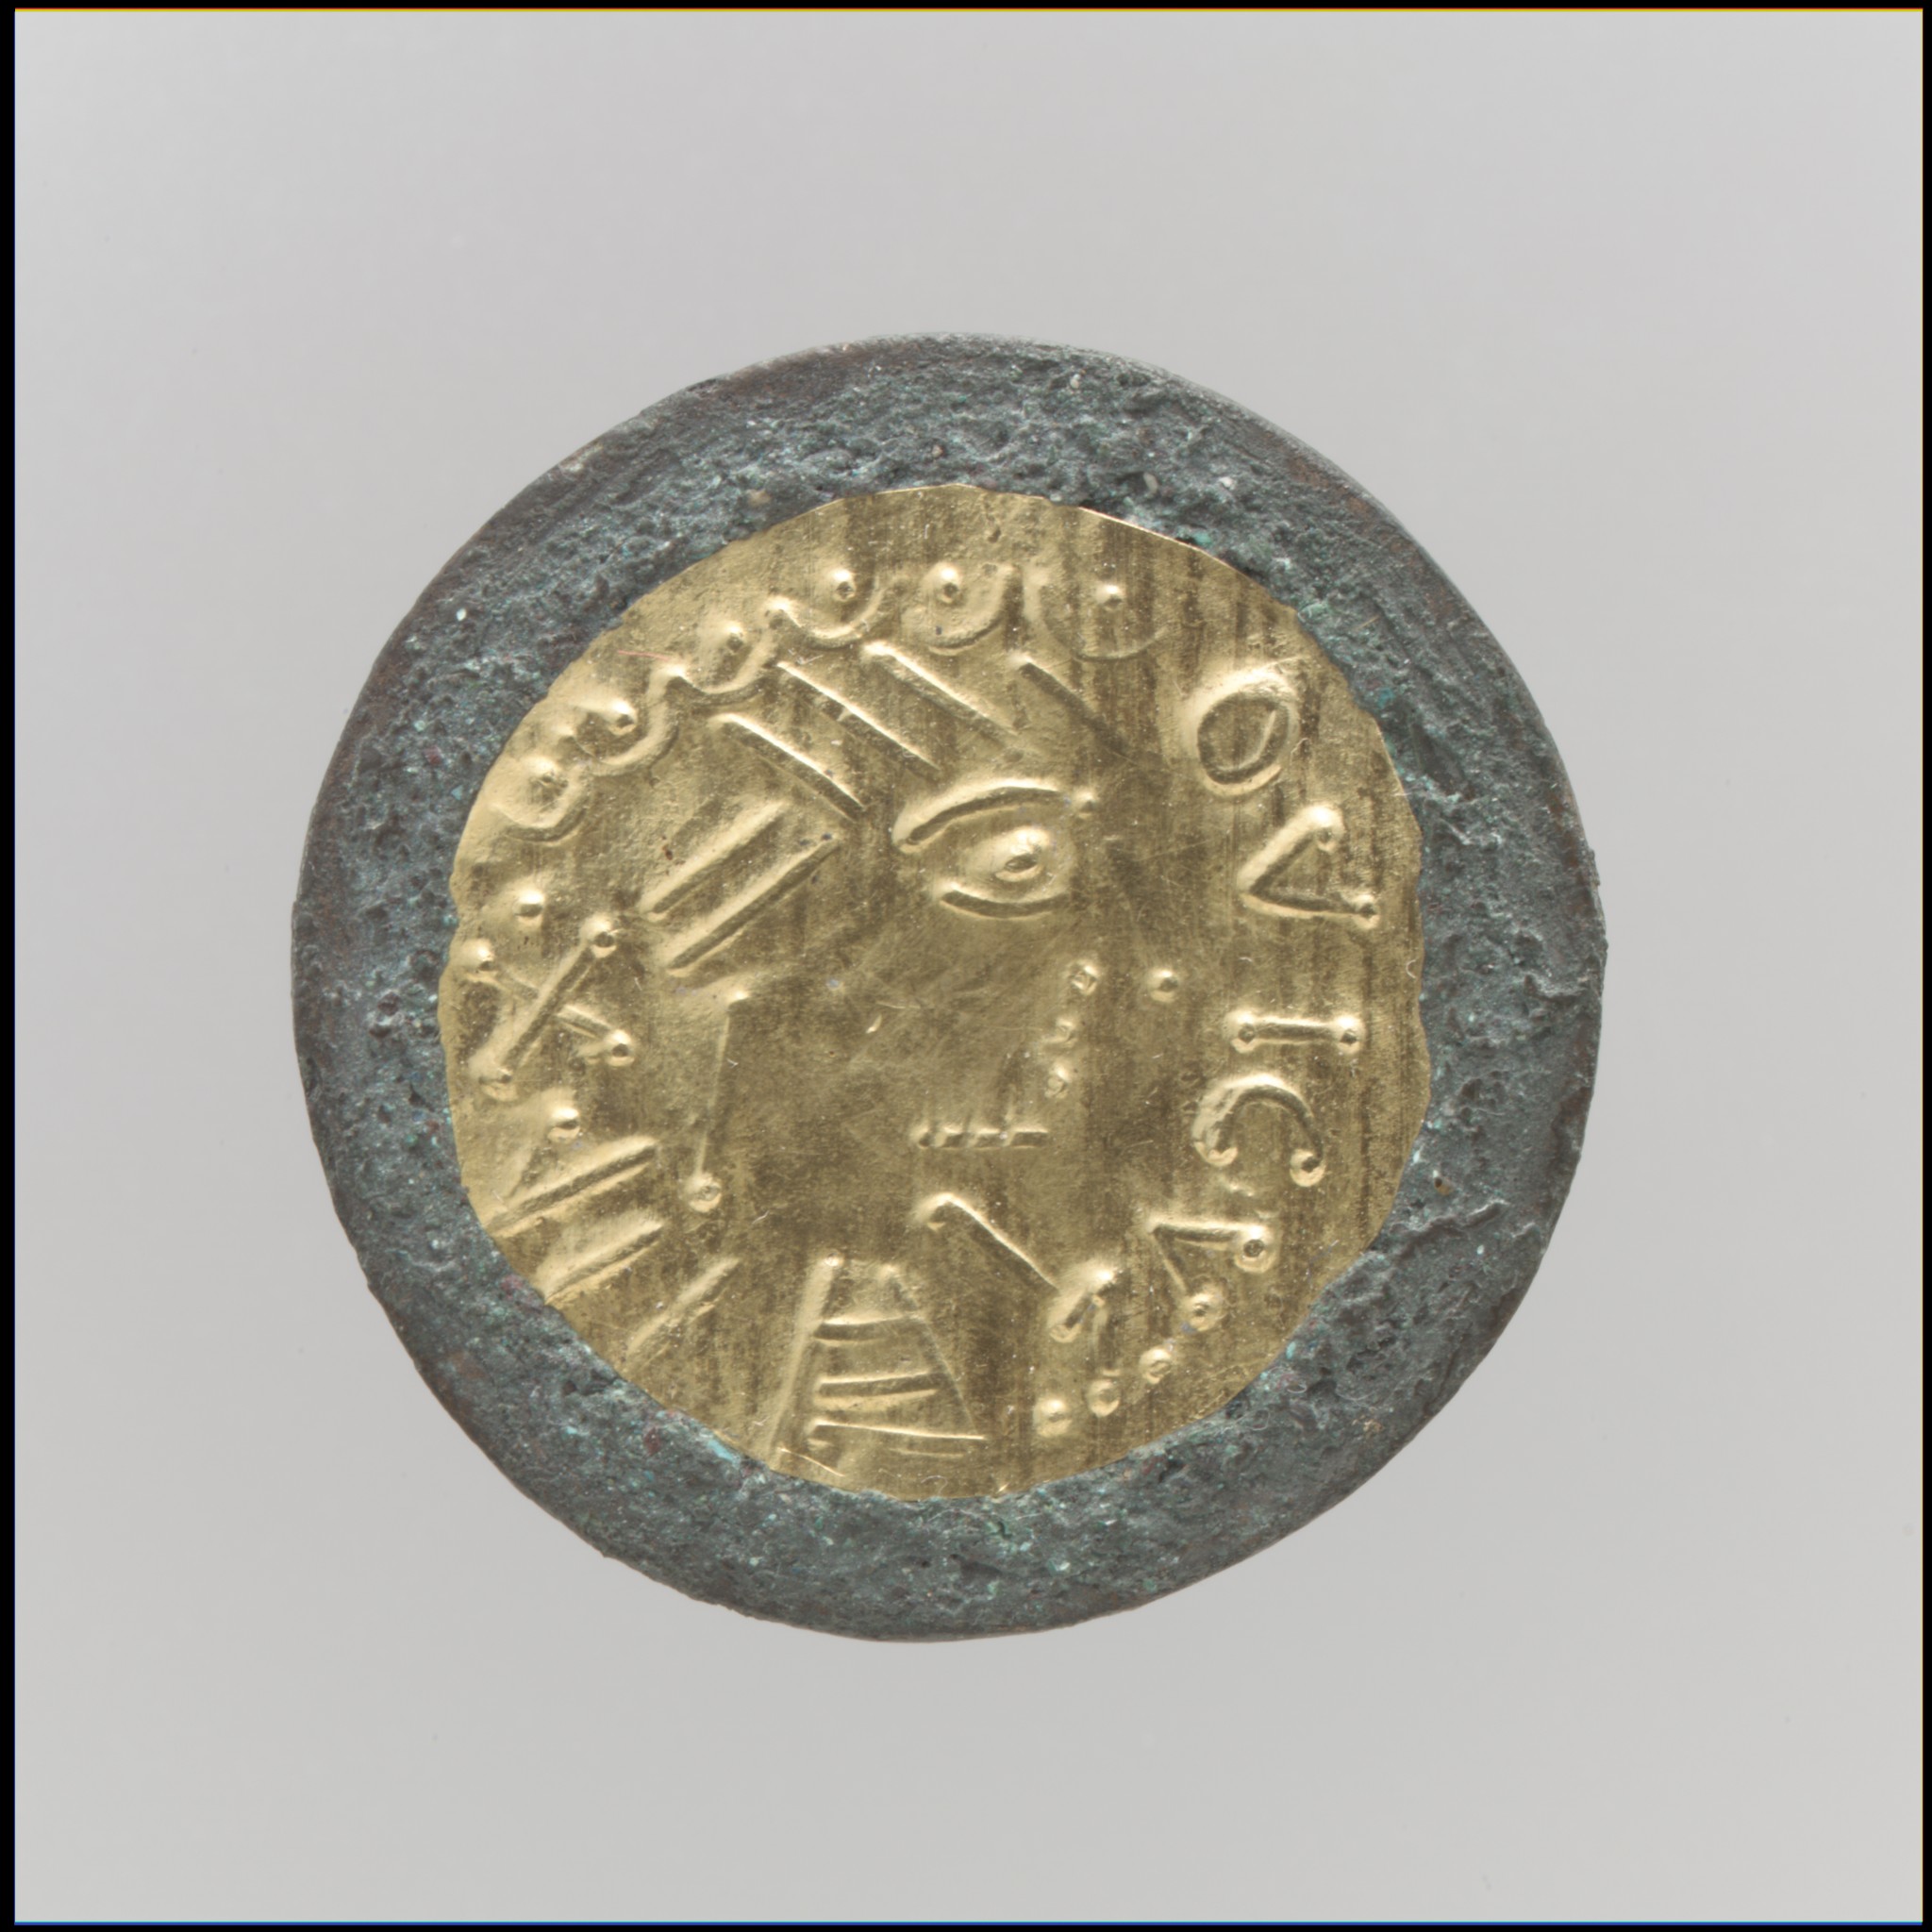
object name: brooch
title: Gold Disk Brooch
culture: frankish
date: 601-700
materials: copper alloy, gold, iron